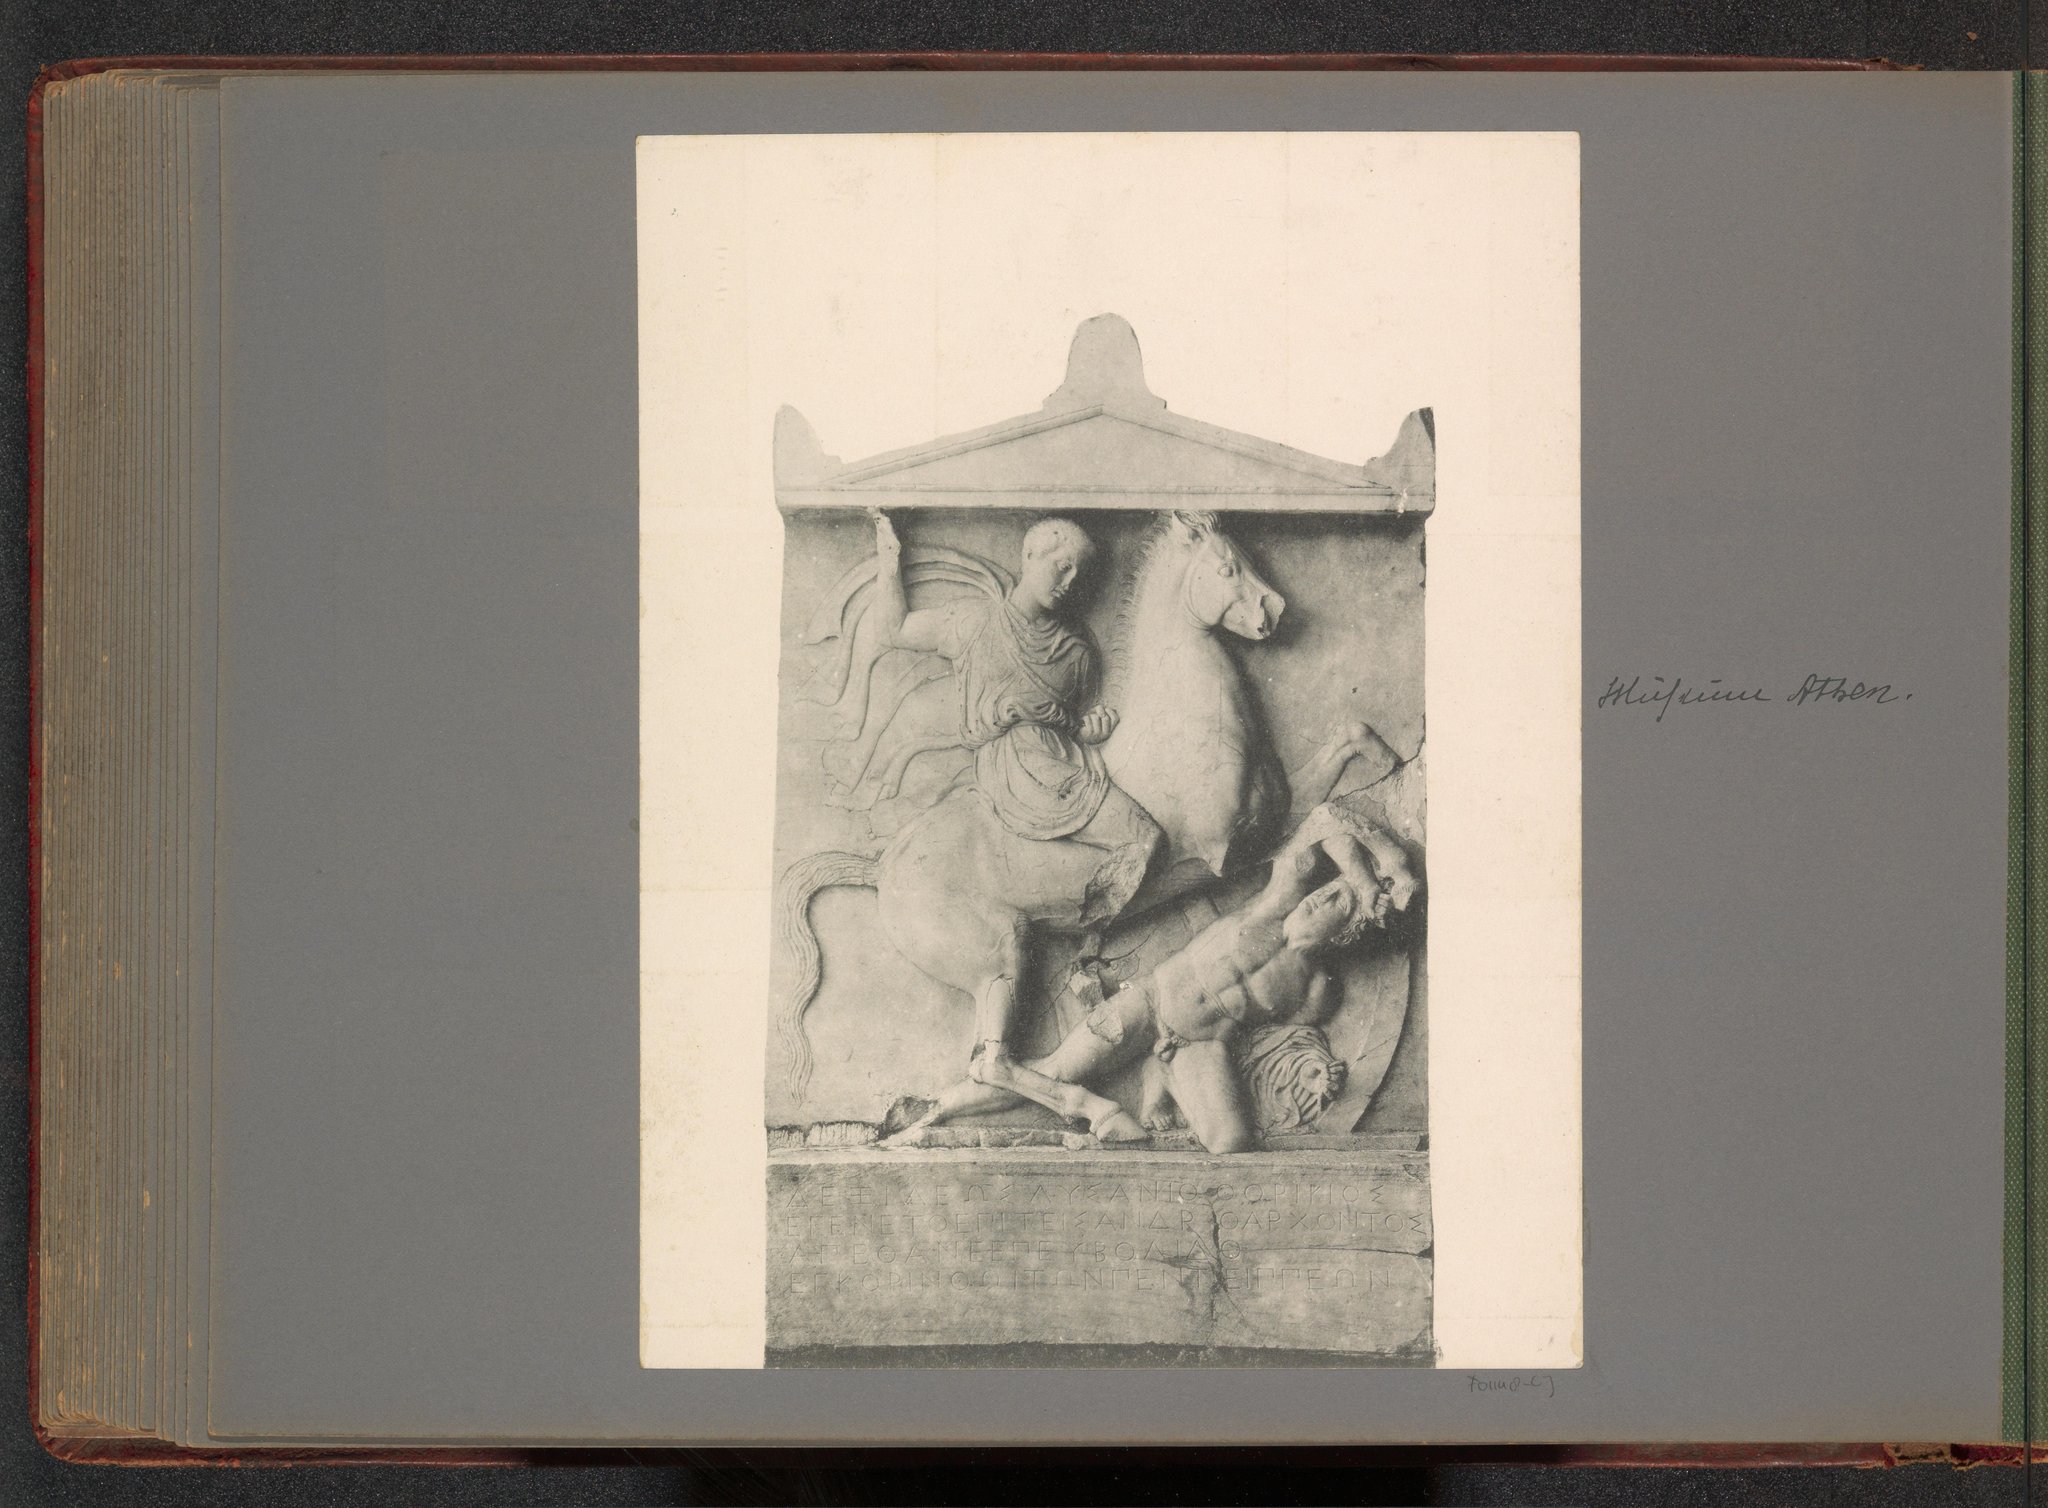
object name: photograph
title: Stèle van Dexileos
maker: Anonymous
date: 1903-1905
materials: paper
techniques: photograph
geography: greece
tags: sculpture (+ relief ~ sculpture)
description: Onderdeel van Reisalbum met foto's van bezienswaardigheden in Griekenland en Egypte.